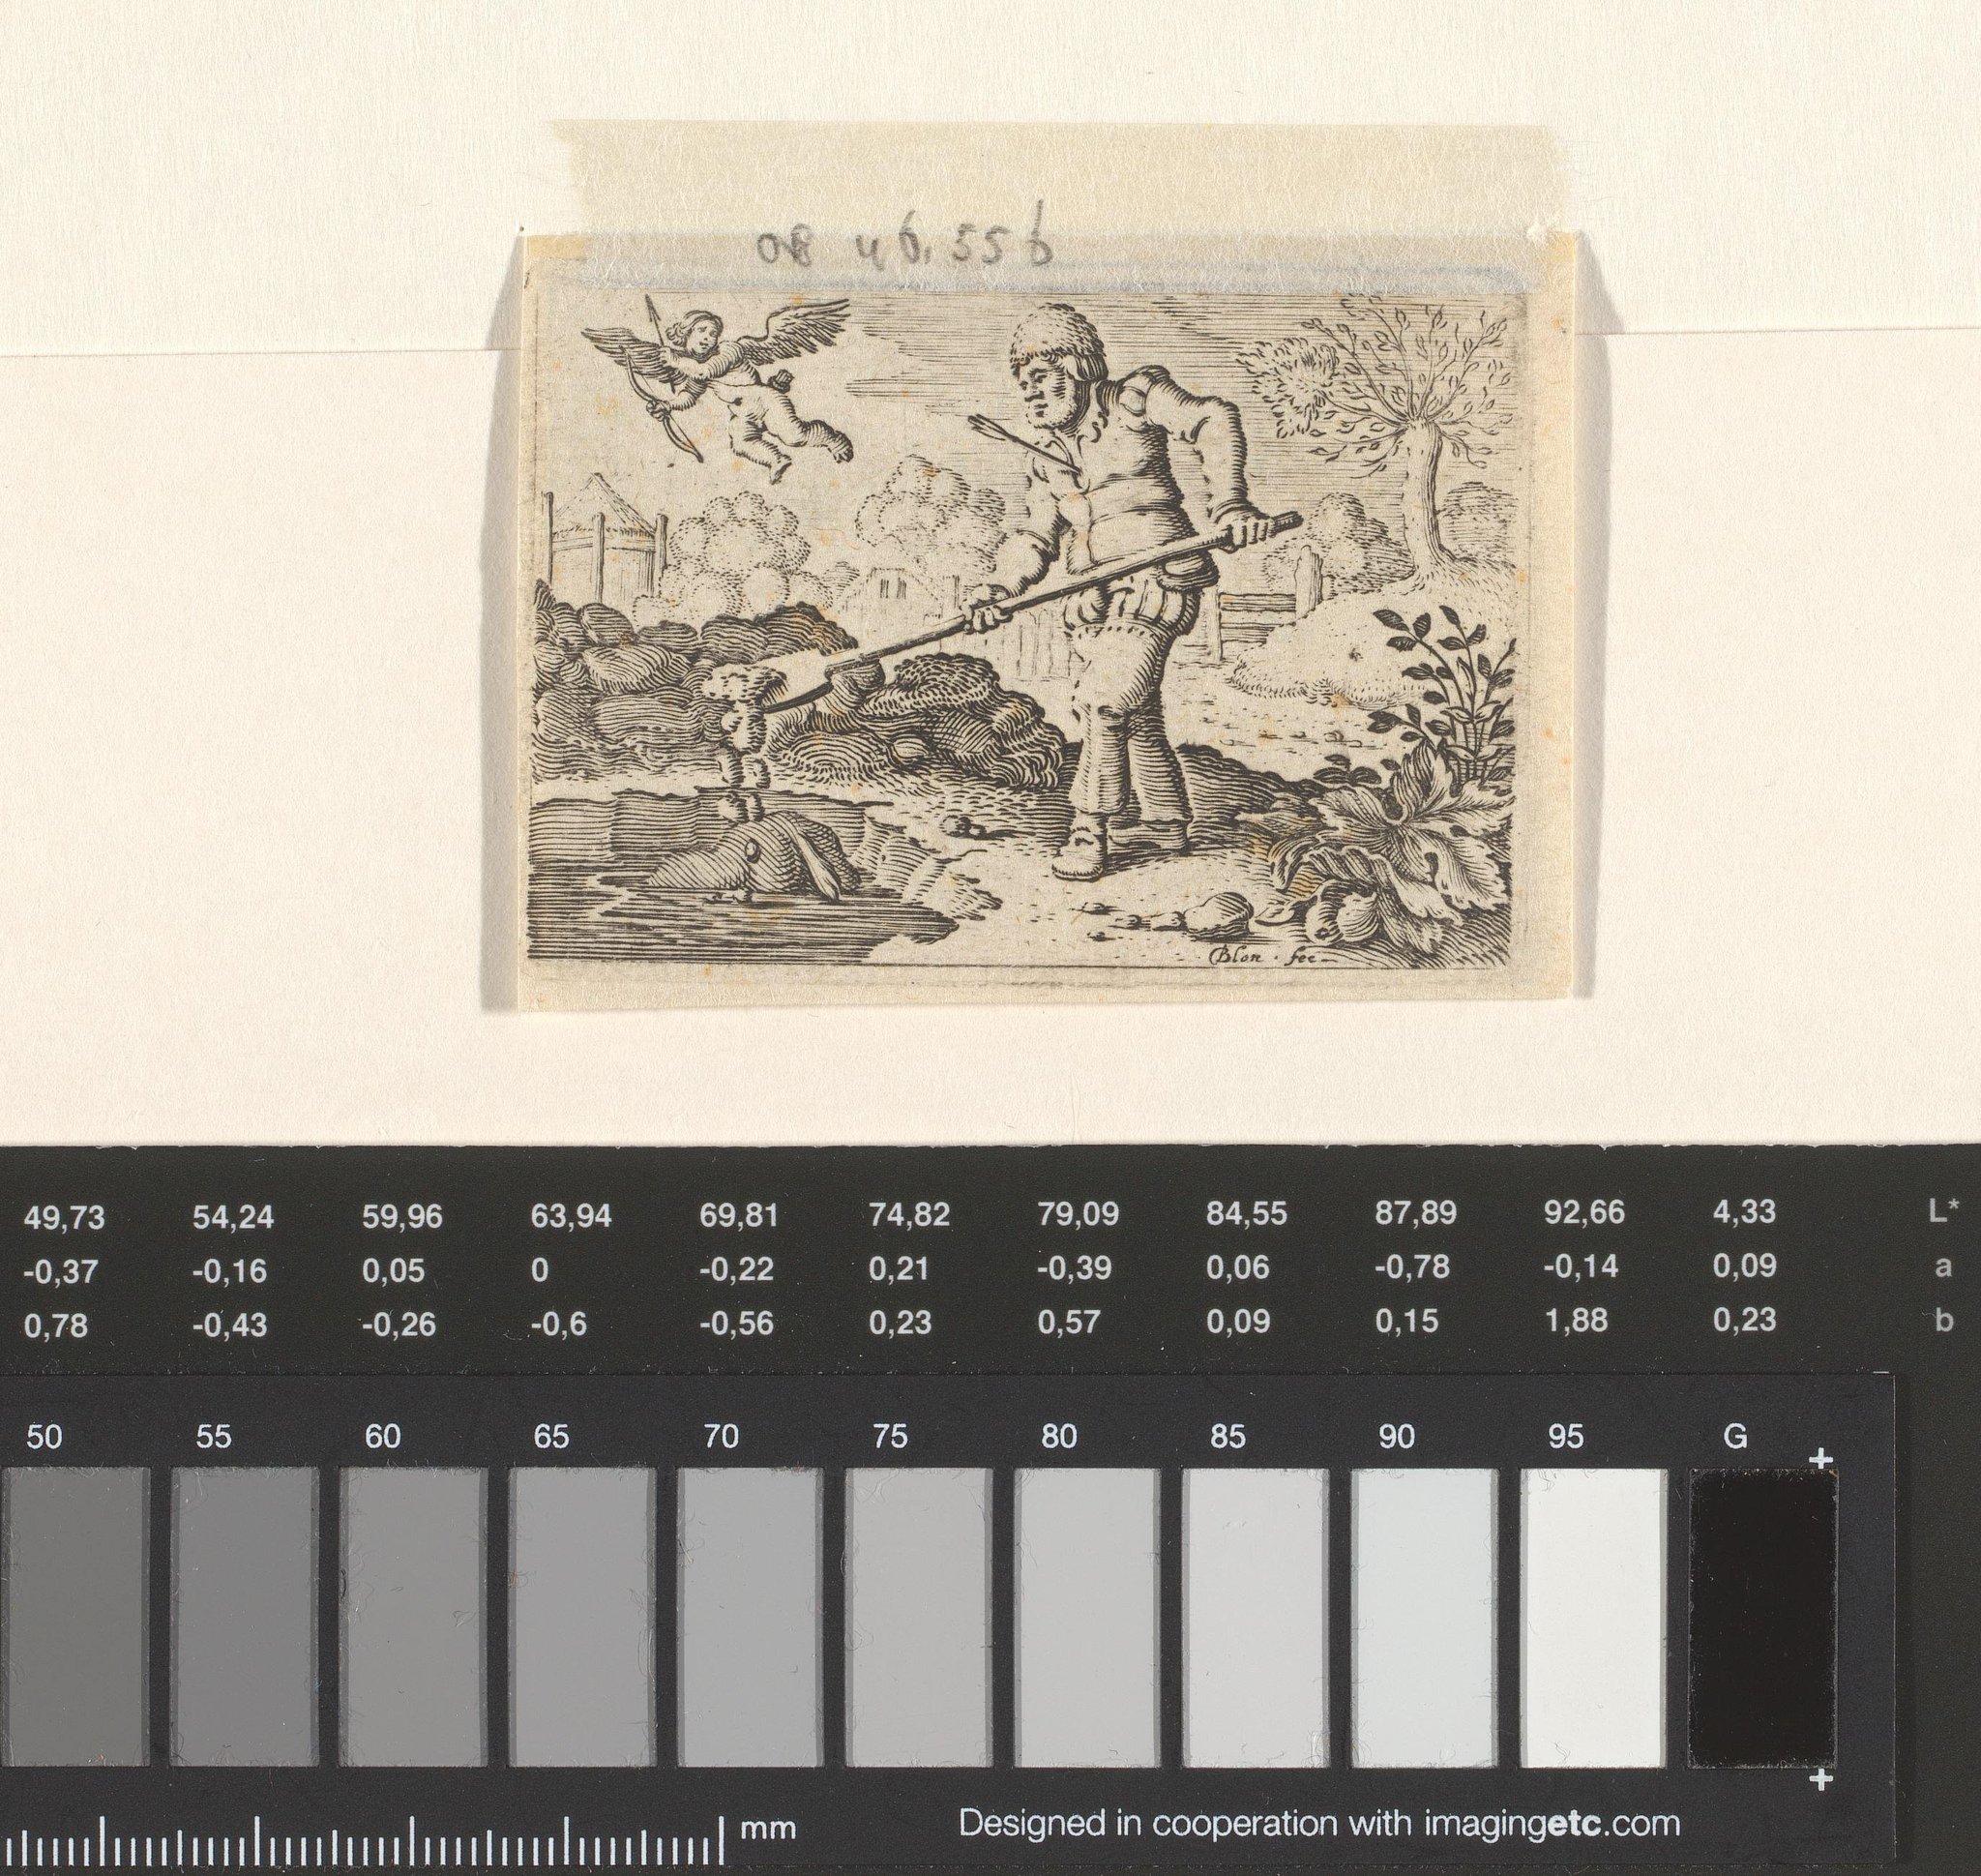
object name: print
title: Verdronken paard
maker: michiel le blon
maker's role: print maker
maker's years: 1587-1656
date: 1616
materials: paper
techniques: engraving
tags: accidental death ~ water (+ variant), (story of) cupid, amor (eros), horse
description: Een boer, wiens hart is doorboord met de pijl van Amor, begraaft met een schep zijn verdronken paard in een kuil. In de lucht vliegt Amor. De prent maakt deel uit van een serie prenten met liefdesemblemen.